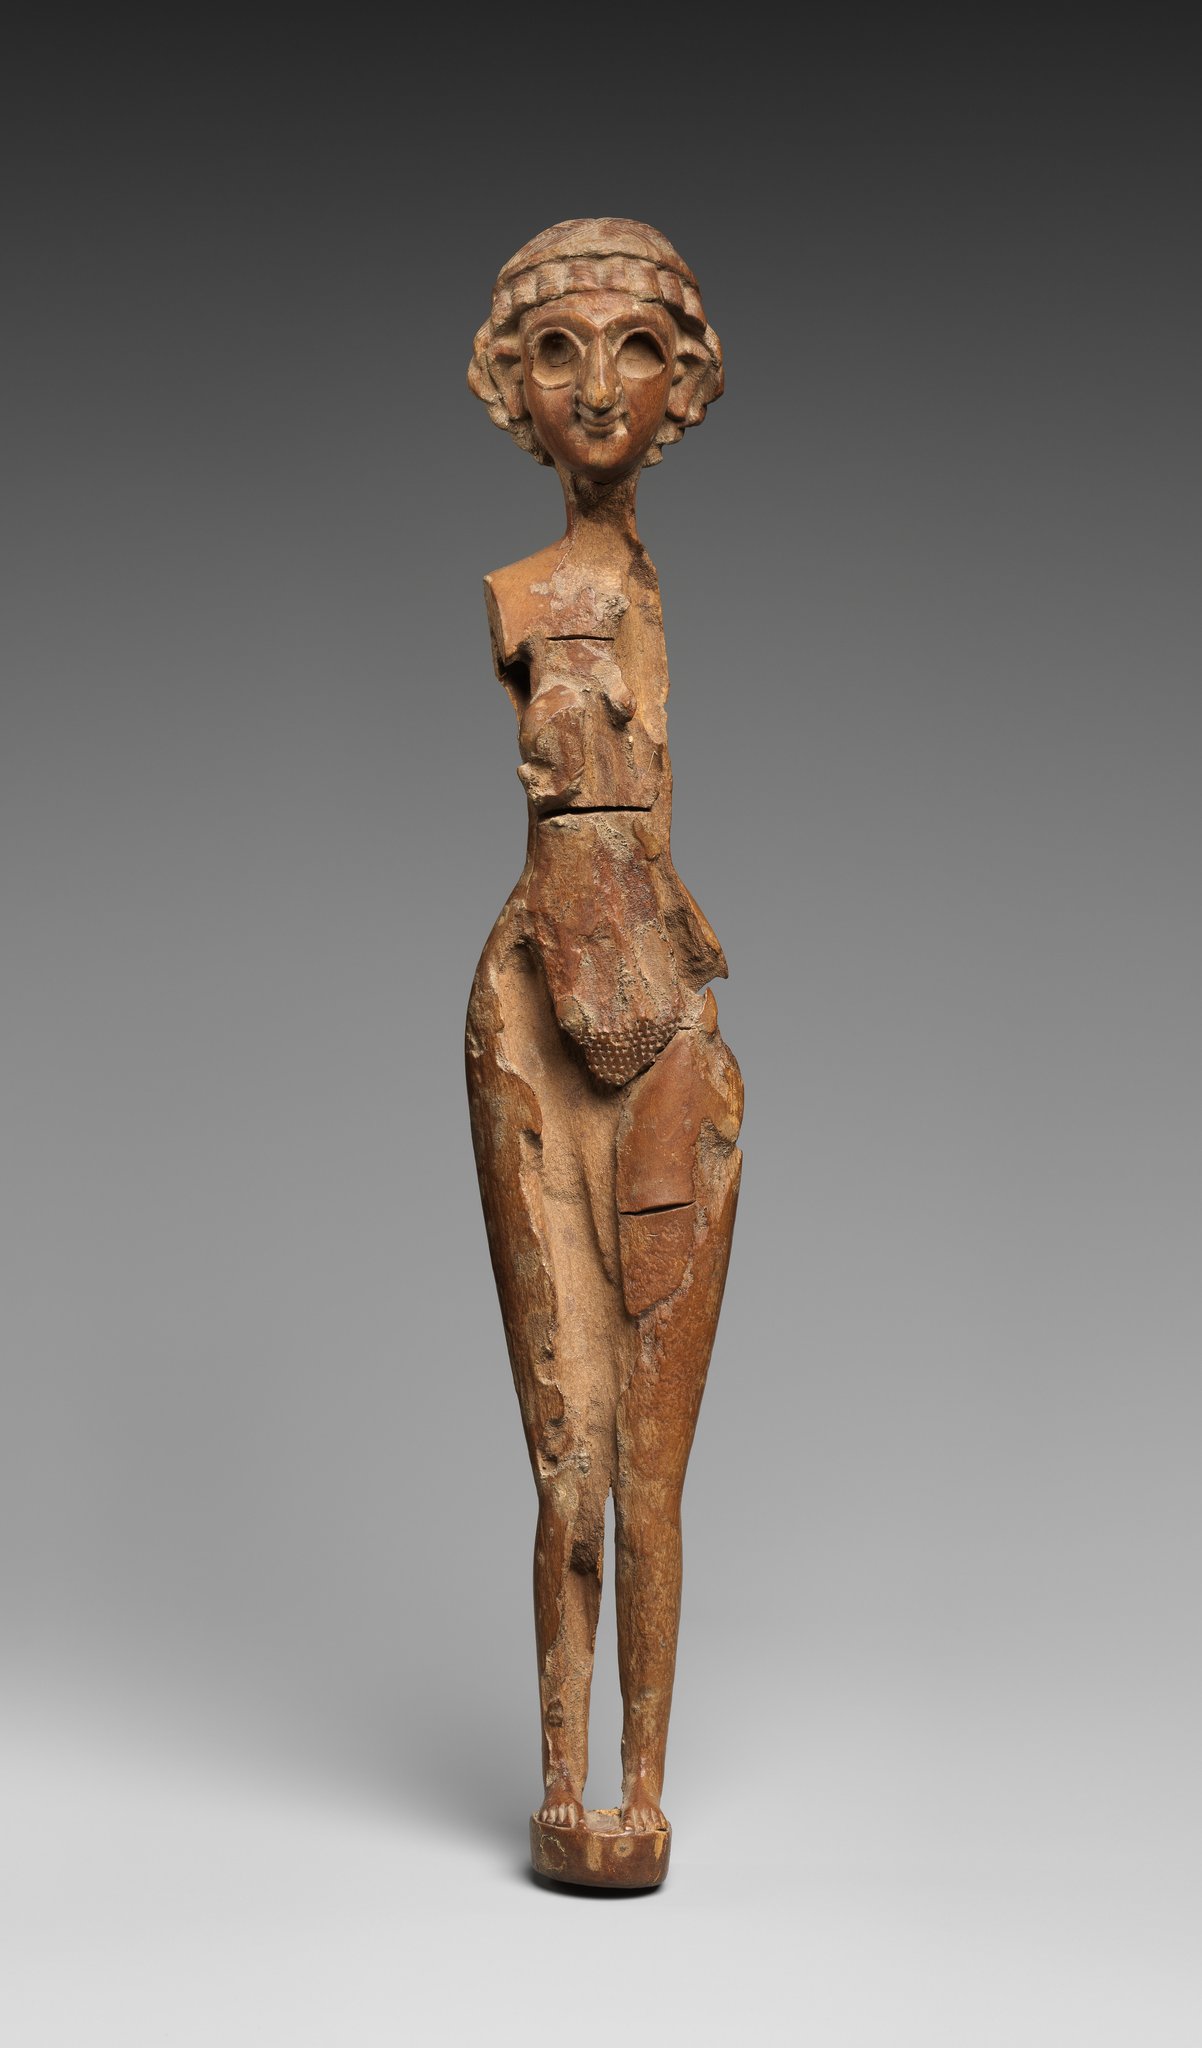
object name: sculpture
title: Syrian-style nude female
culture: syrian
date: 1500-1401 BCE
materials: wood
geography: upper egypt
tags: female nudes